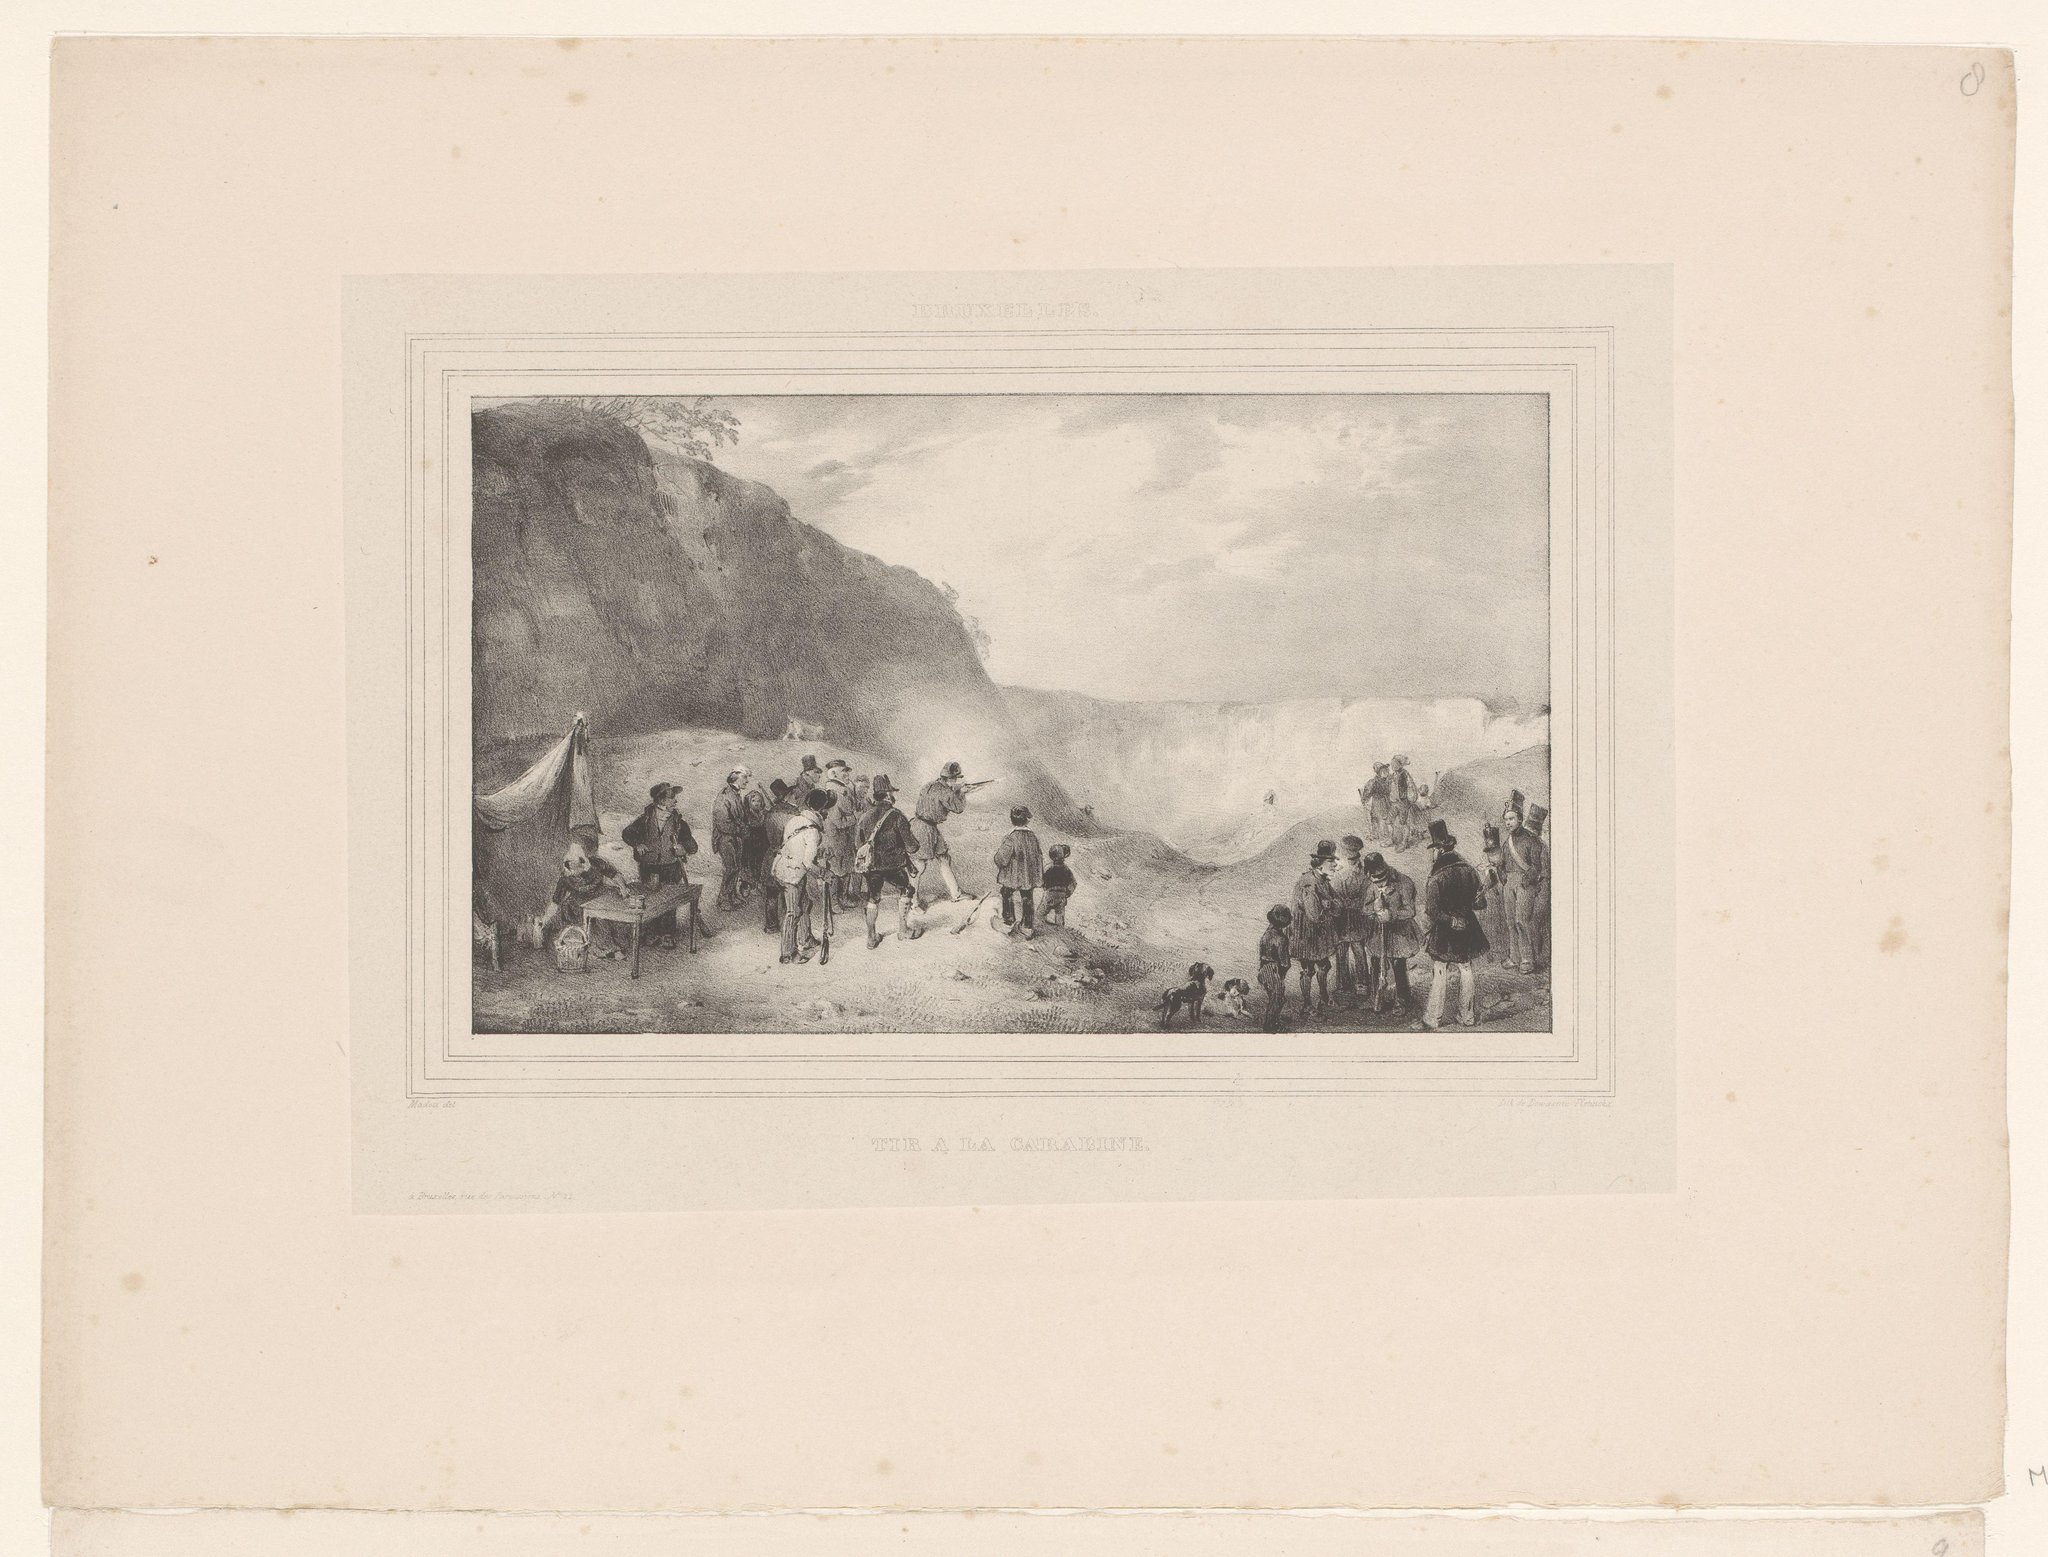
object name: print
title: Bruxelles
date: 1831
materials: paper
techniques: lithograph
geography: brussels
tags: low hill country (+ landscape with figures, staffage), firearms: rifle, brussels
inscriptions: collector's mark: Lugt 2228